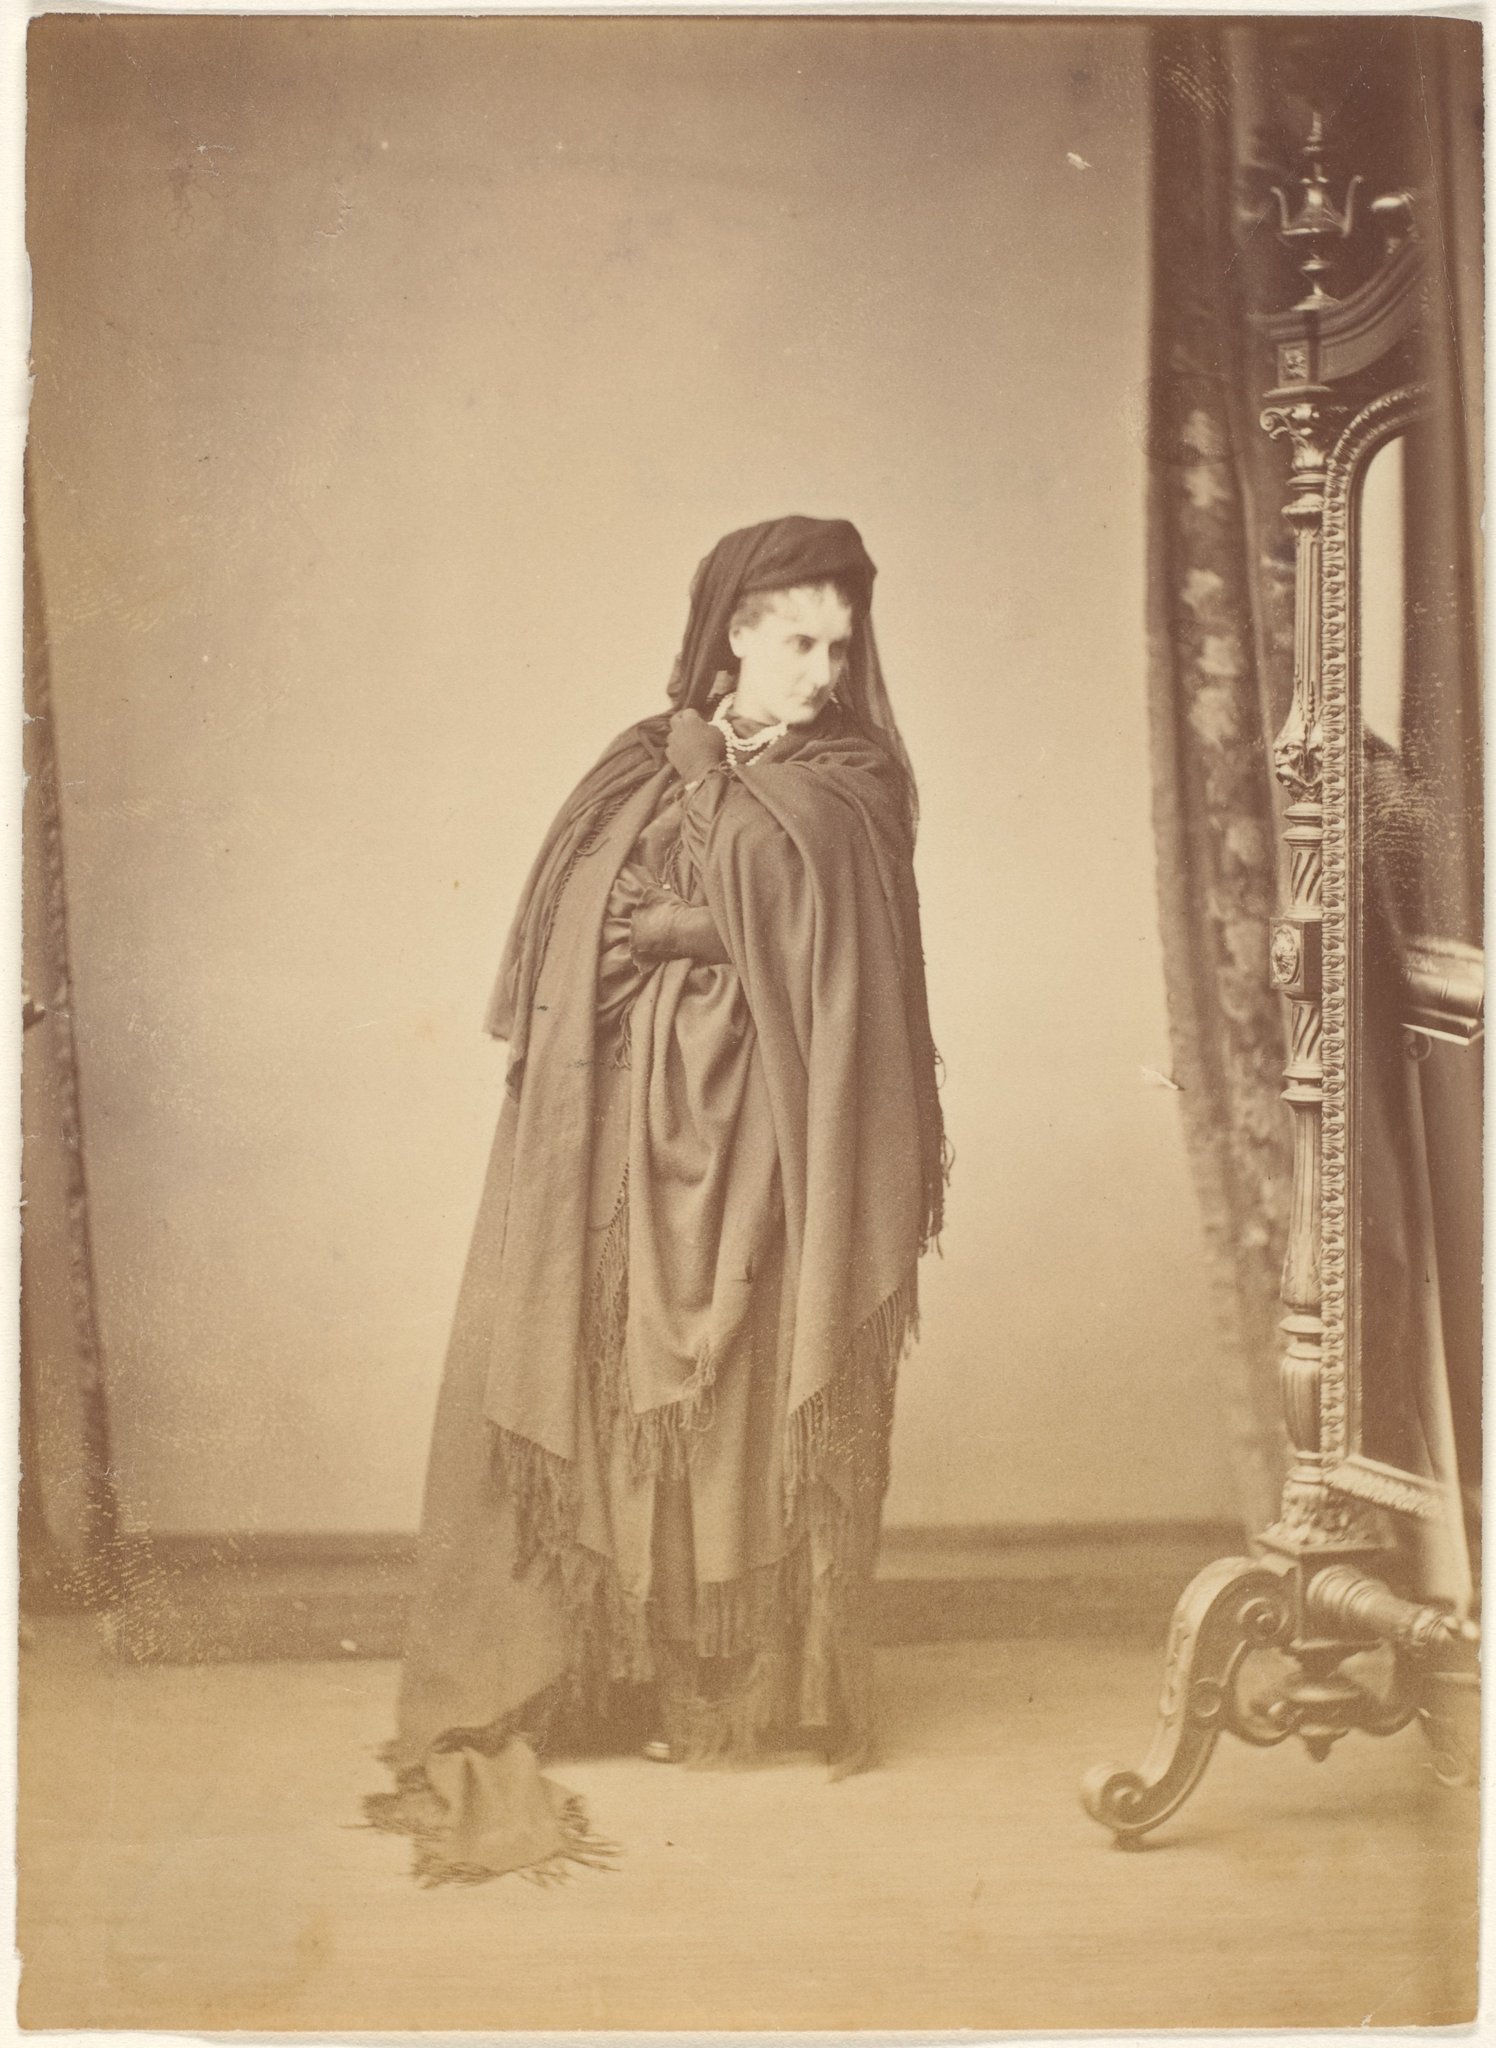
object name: photograph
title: Sèriè à la Ristori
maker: pierre-louis pierson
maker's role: artist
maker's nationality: french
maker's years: 1822-1913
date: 1860-1869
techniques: albumen silver print, glass negative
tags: portraits,women